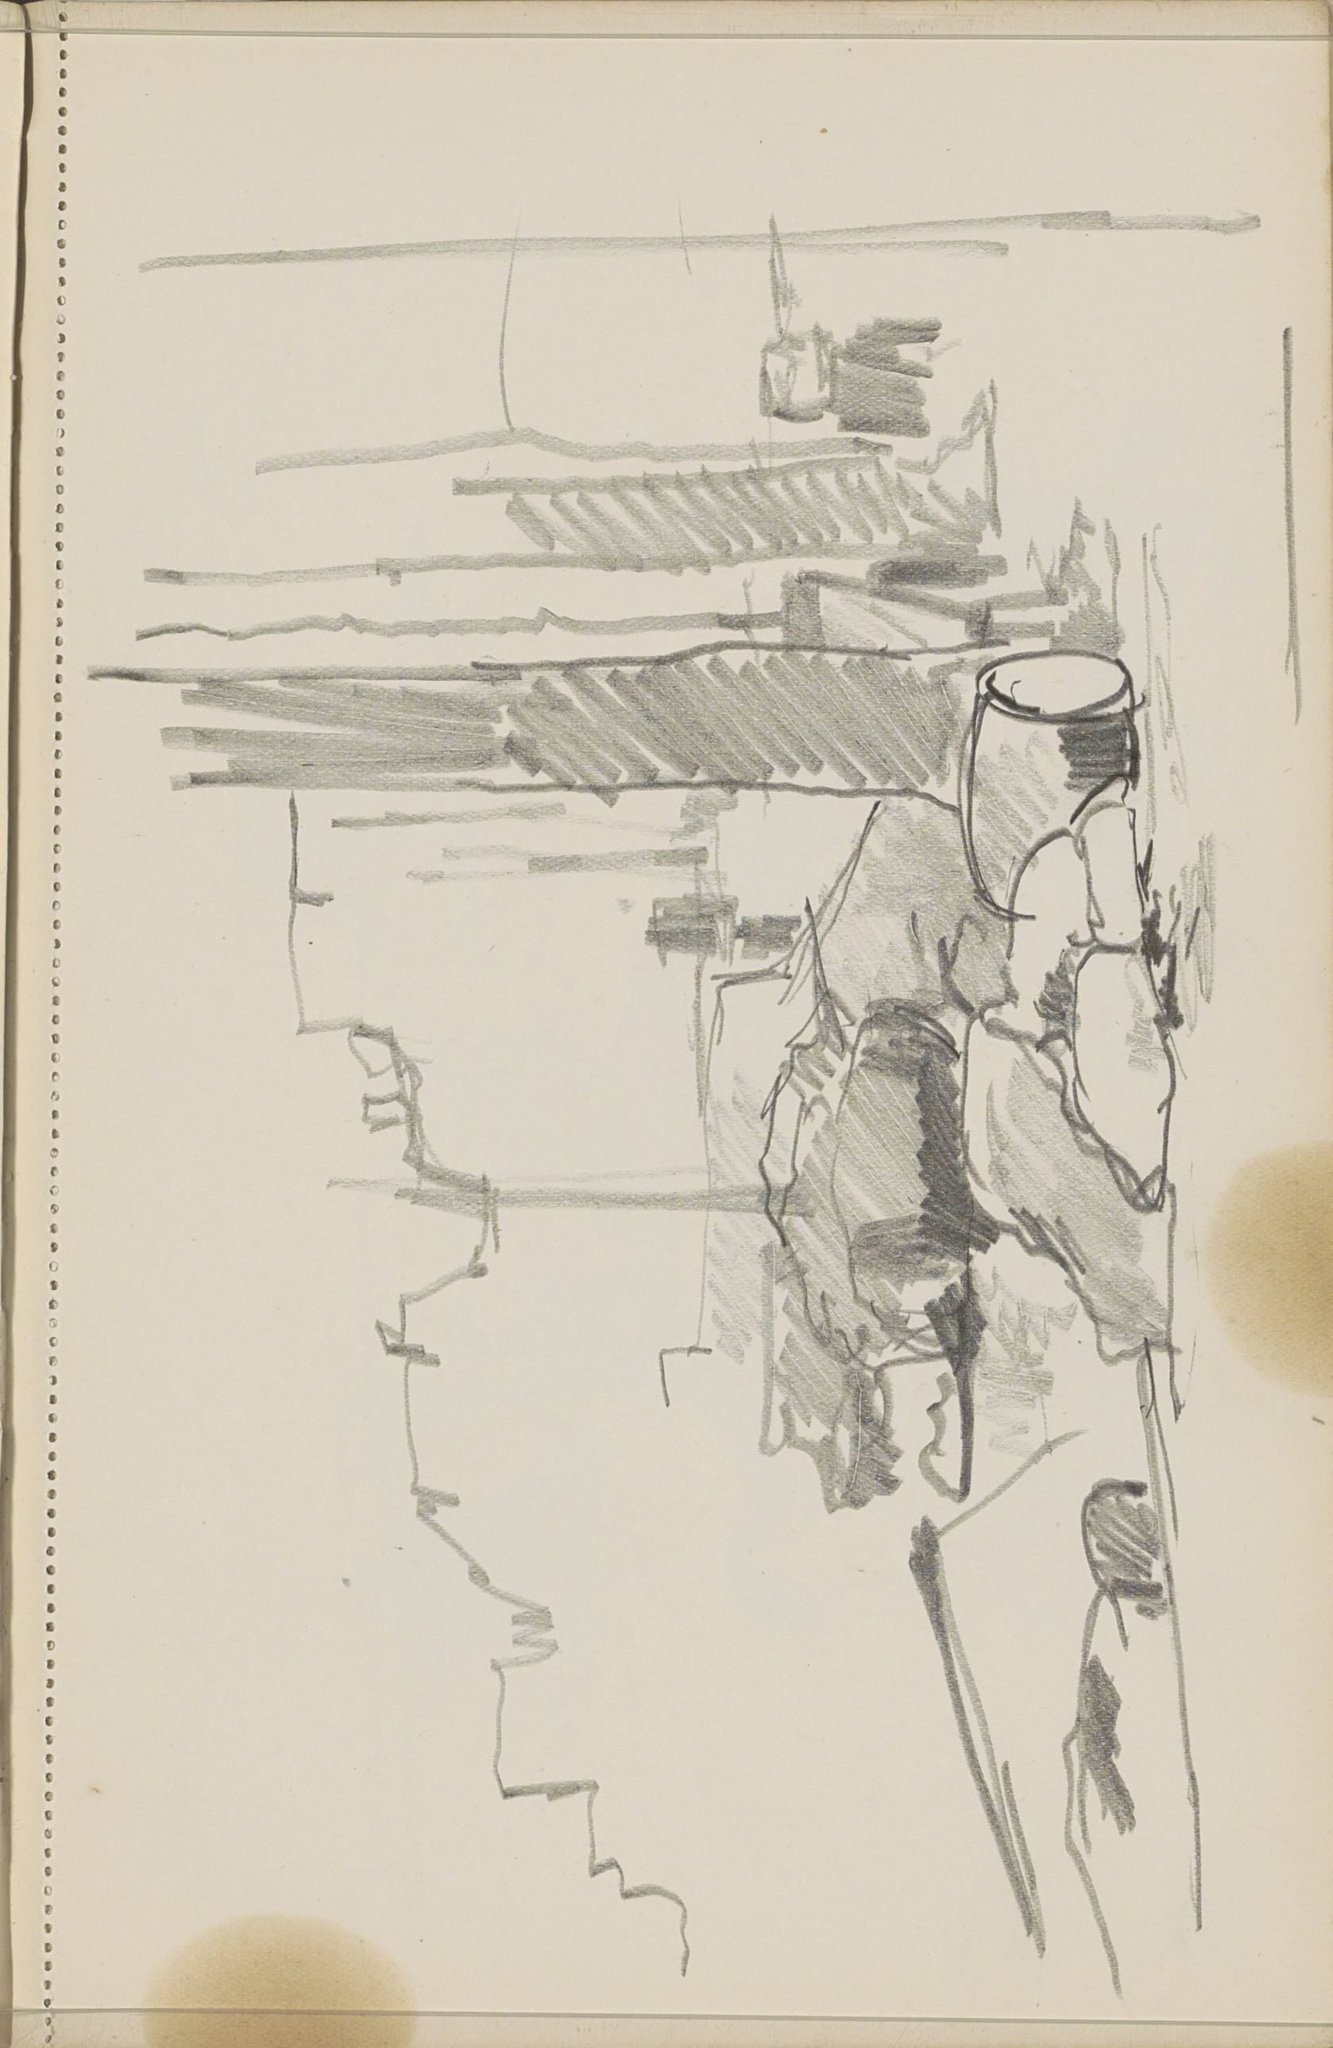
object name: sketchbook leaf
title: Kade van een gracht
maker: cornelis vreedenburgh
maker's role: draughtsman, print maker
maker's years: 1880-1946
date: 1890-1946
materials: paper, pencil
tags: canal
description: Langs de kade staan tonnen en liggen pakken. Blad 15 recto uit een schetsboek met 59 bladen.